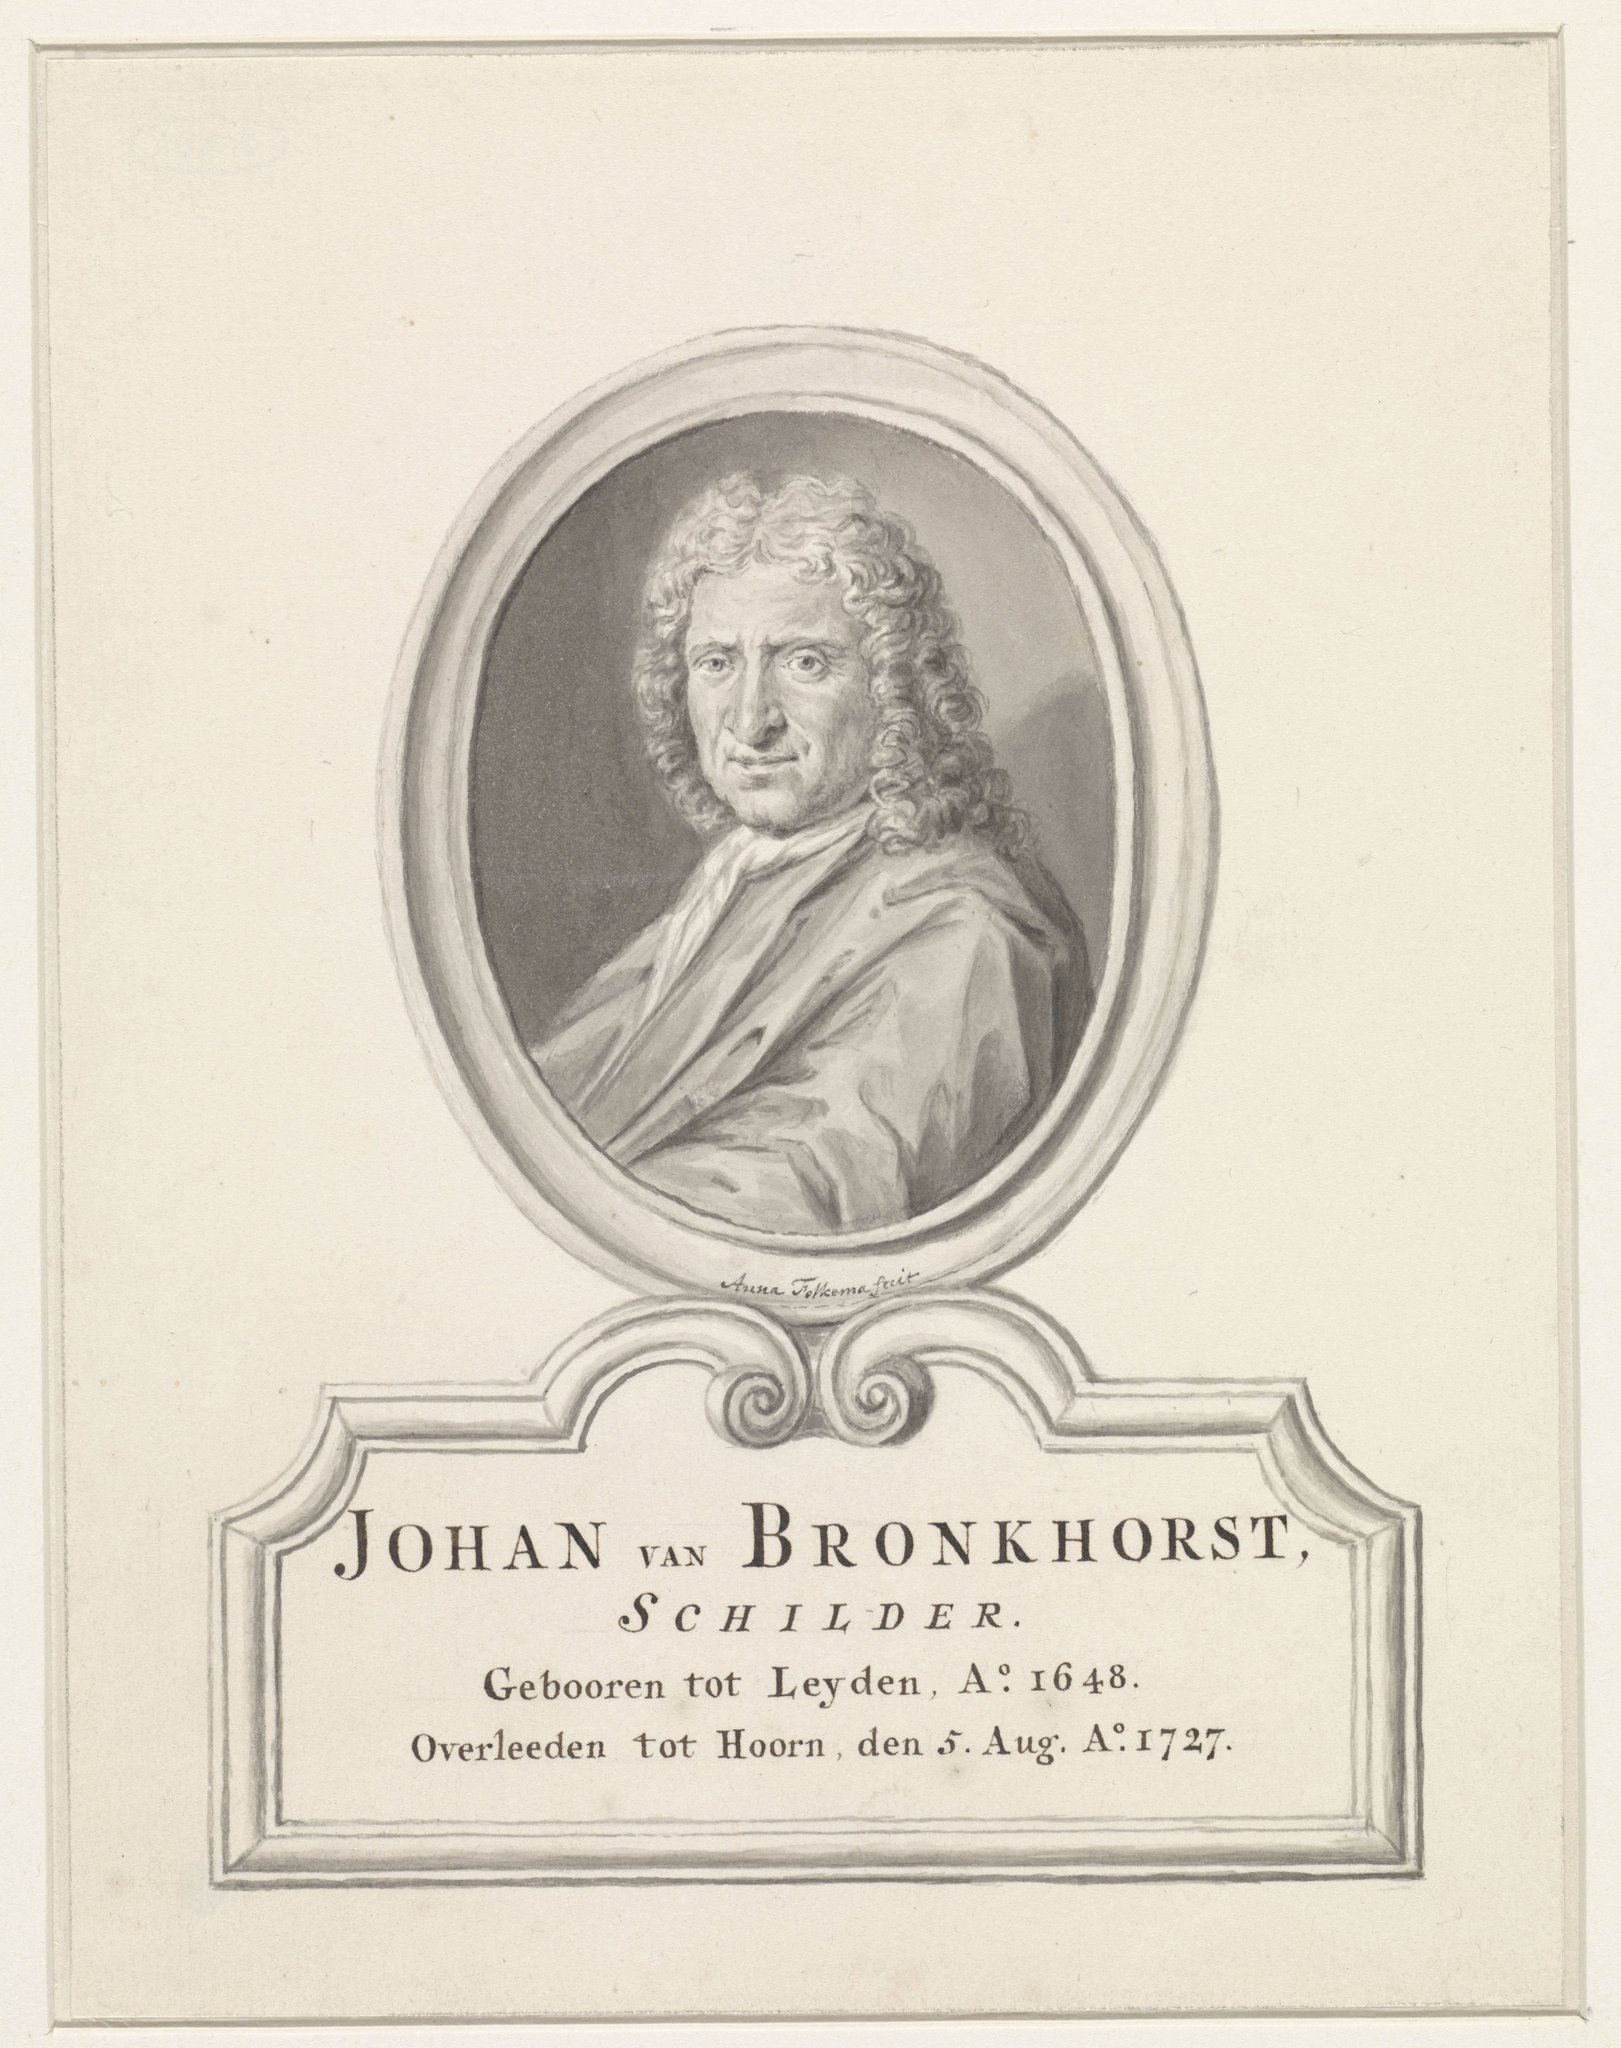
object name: drawing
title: Portret van Johannes Bronkhorst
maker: anna folkema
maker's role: draughtsman, print maker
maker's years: 1695-1768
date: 1705-1768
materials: paper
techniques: brush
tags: leiden, johannes bronkhorst, portrait, self-portrait of painter, portrait, self-portrait of artist, portrait, self-portrait of draughtsman, historical persons (portraits and scenes from the life)